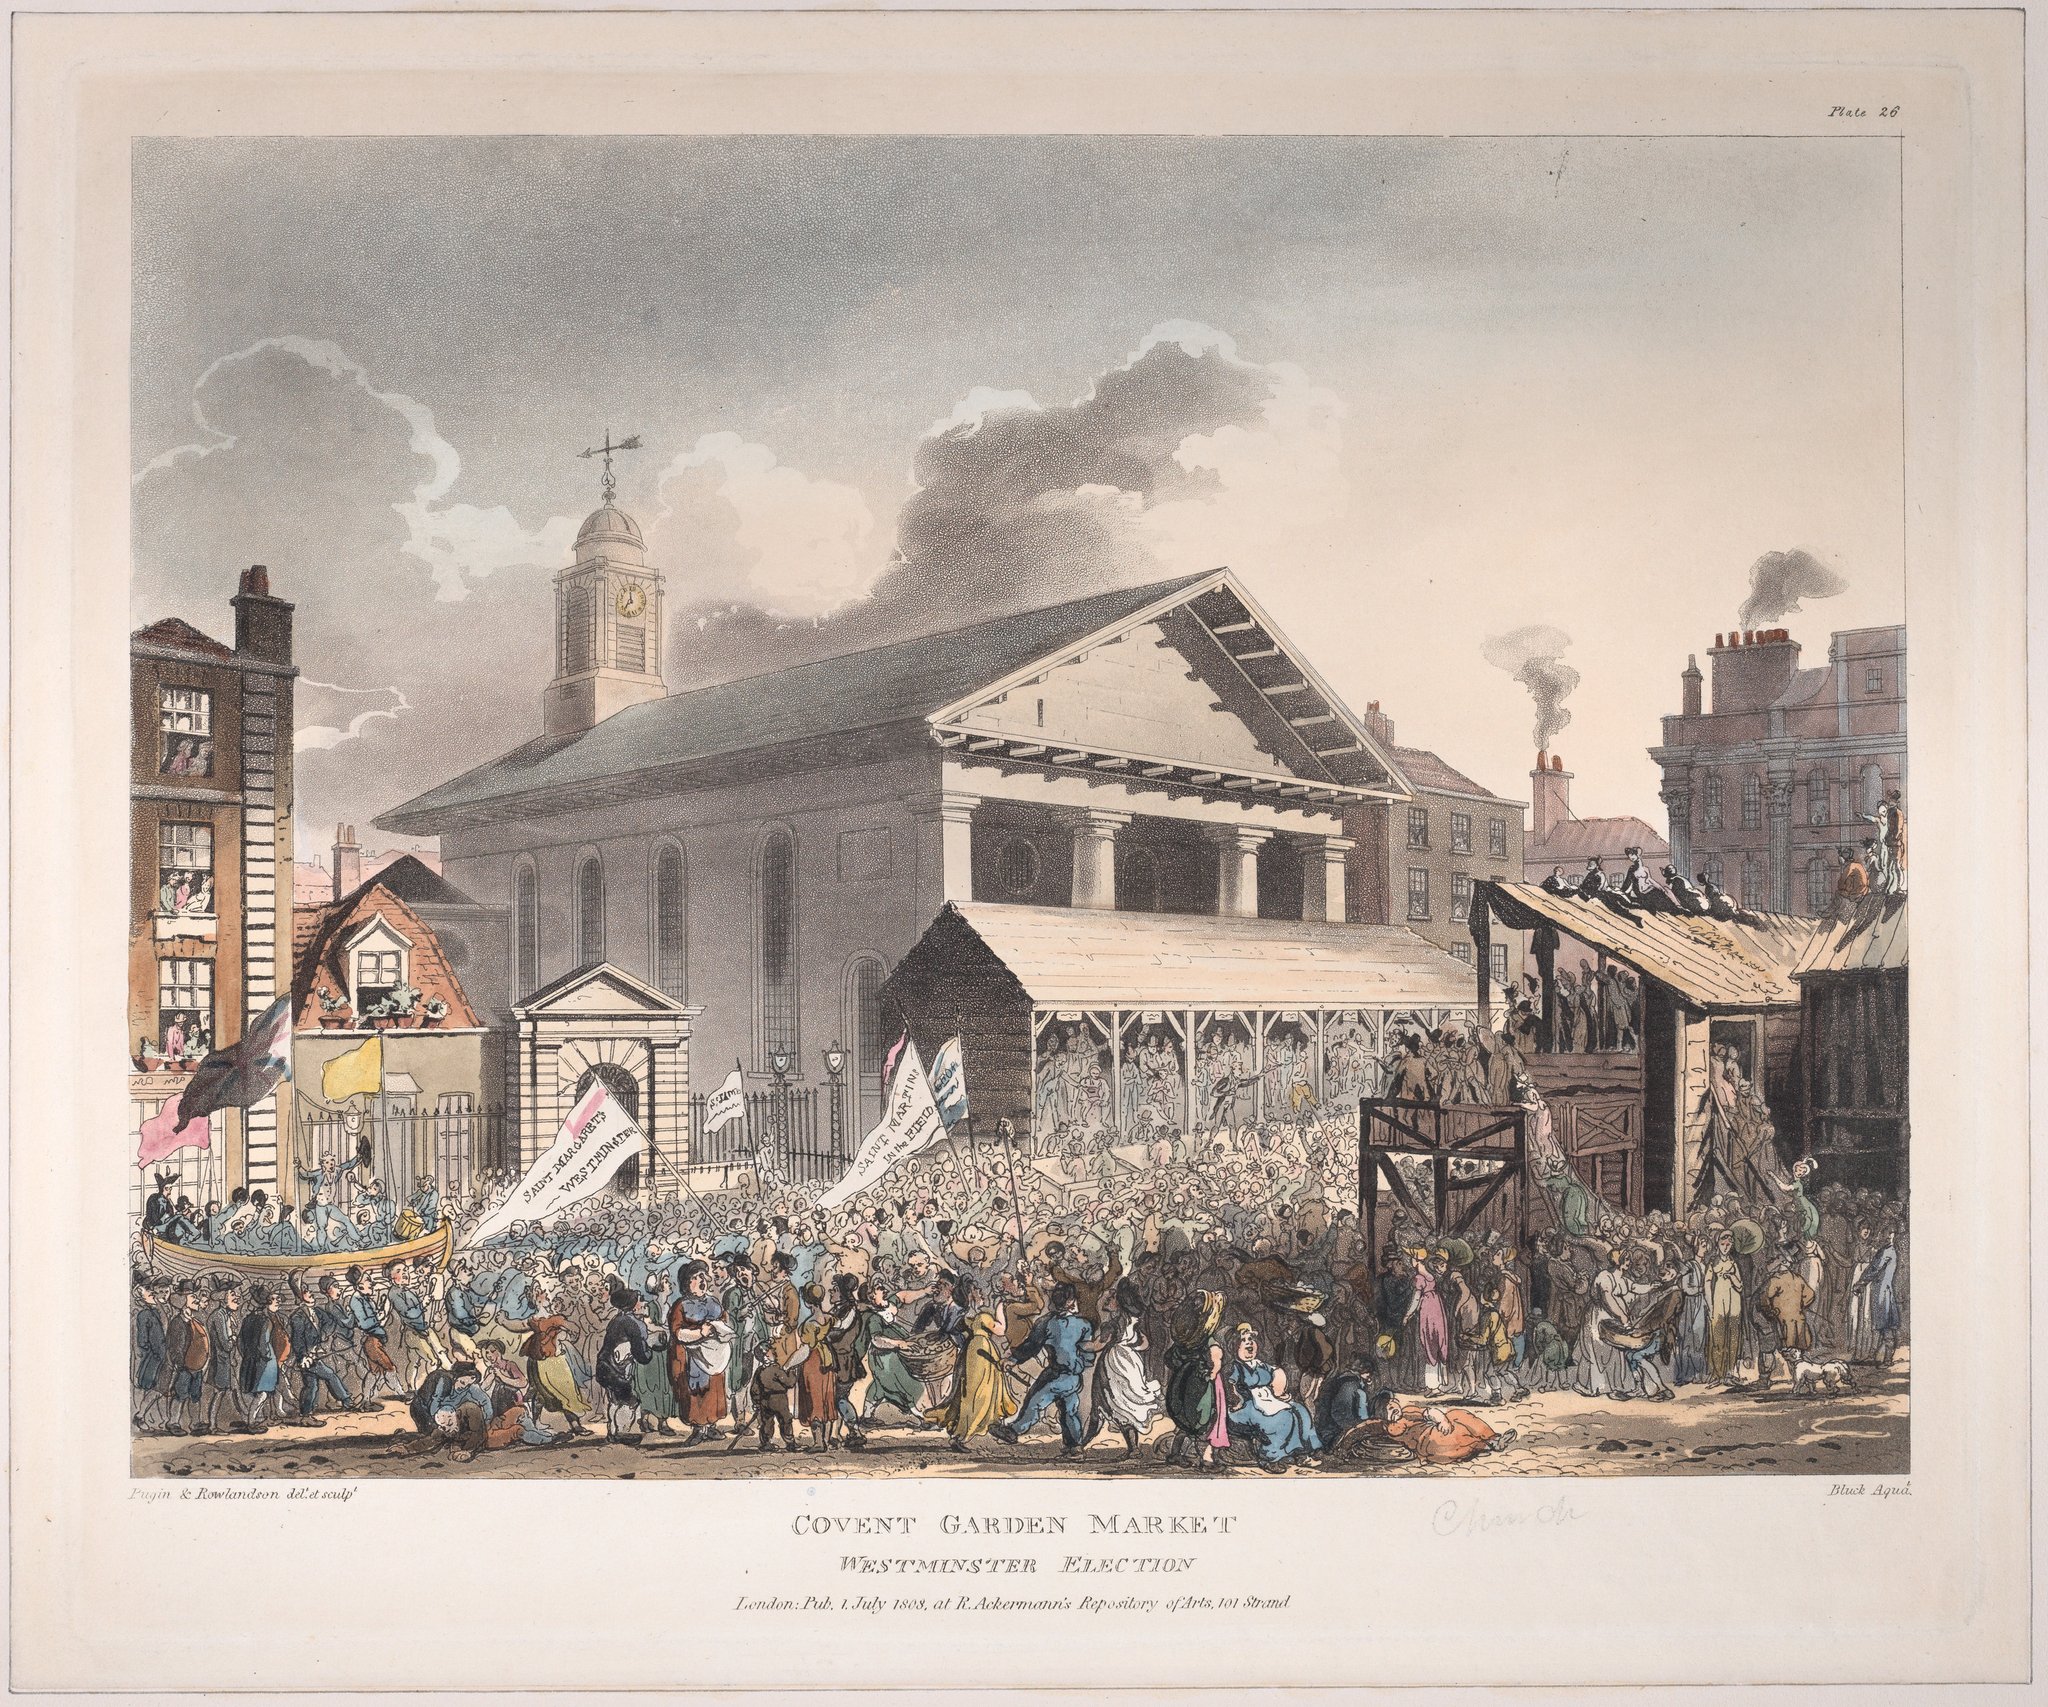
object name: print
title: Covent Garden Market, Westminster Election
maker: thomas rowlandson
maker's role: artist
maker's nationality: british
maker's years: 1757-1827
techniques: aquatint, etching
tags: cities,elections,crowd,politics,london